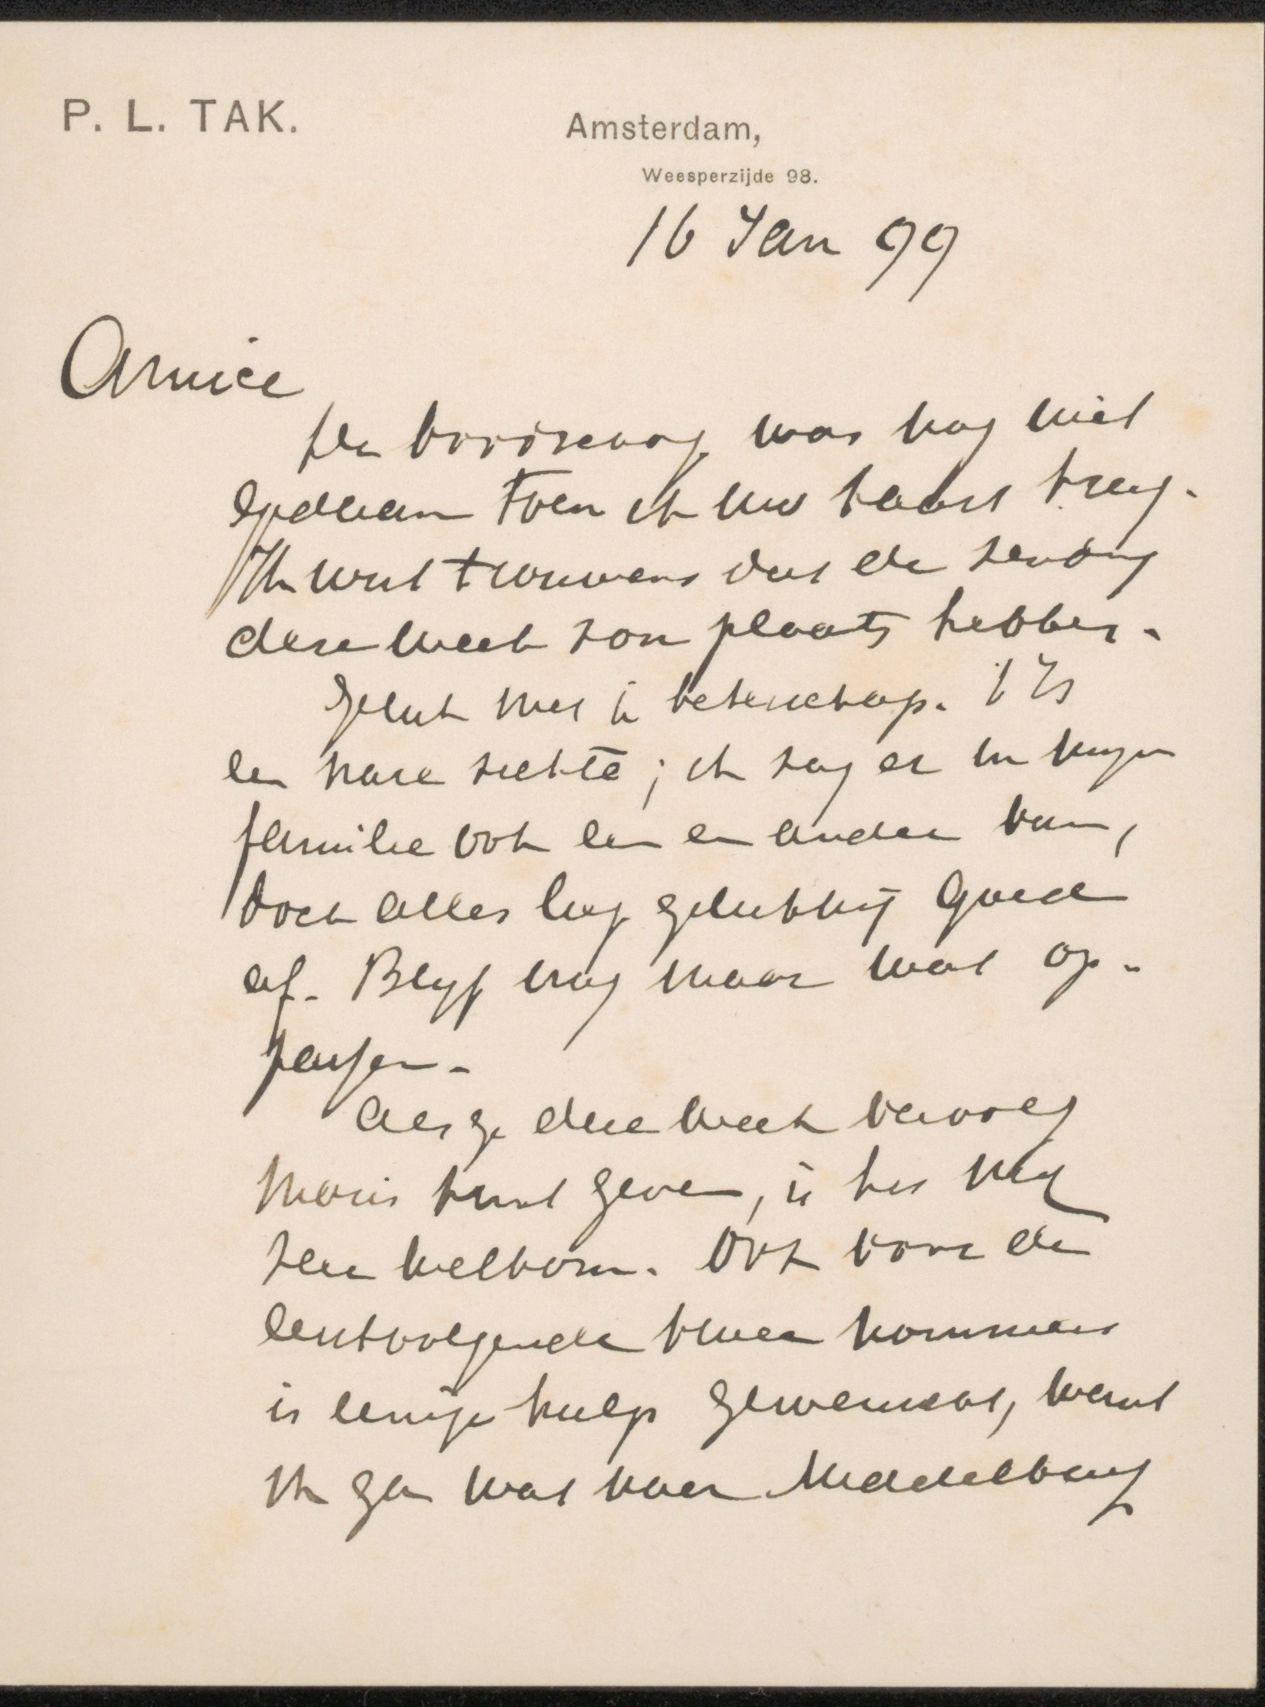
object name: letter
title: Brief aan Jan Veth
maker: pieter lodewijk tak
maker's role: politician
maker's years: 1848-1907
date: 1899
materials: cardboard, ink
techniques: pen, printing, writing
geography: amsterdam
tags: designer, jan veth, painter, print maker, draughtsman, jacob maris, johan henri gustaaf cohen gosschalk, family life, diseases, printed matter, middelburg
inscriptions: collector's mark: ‘RPK’